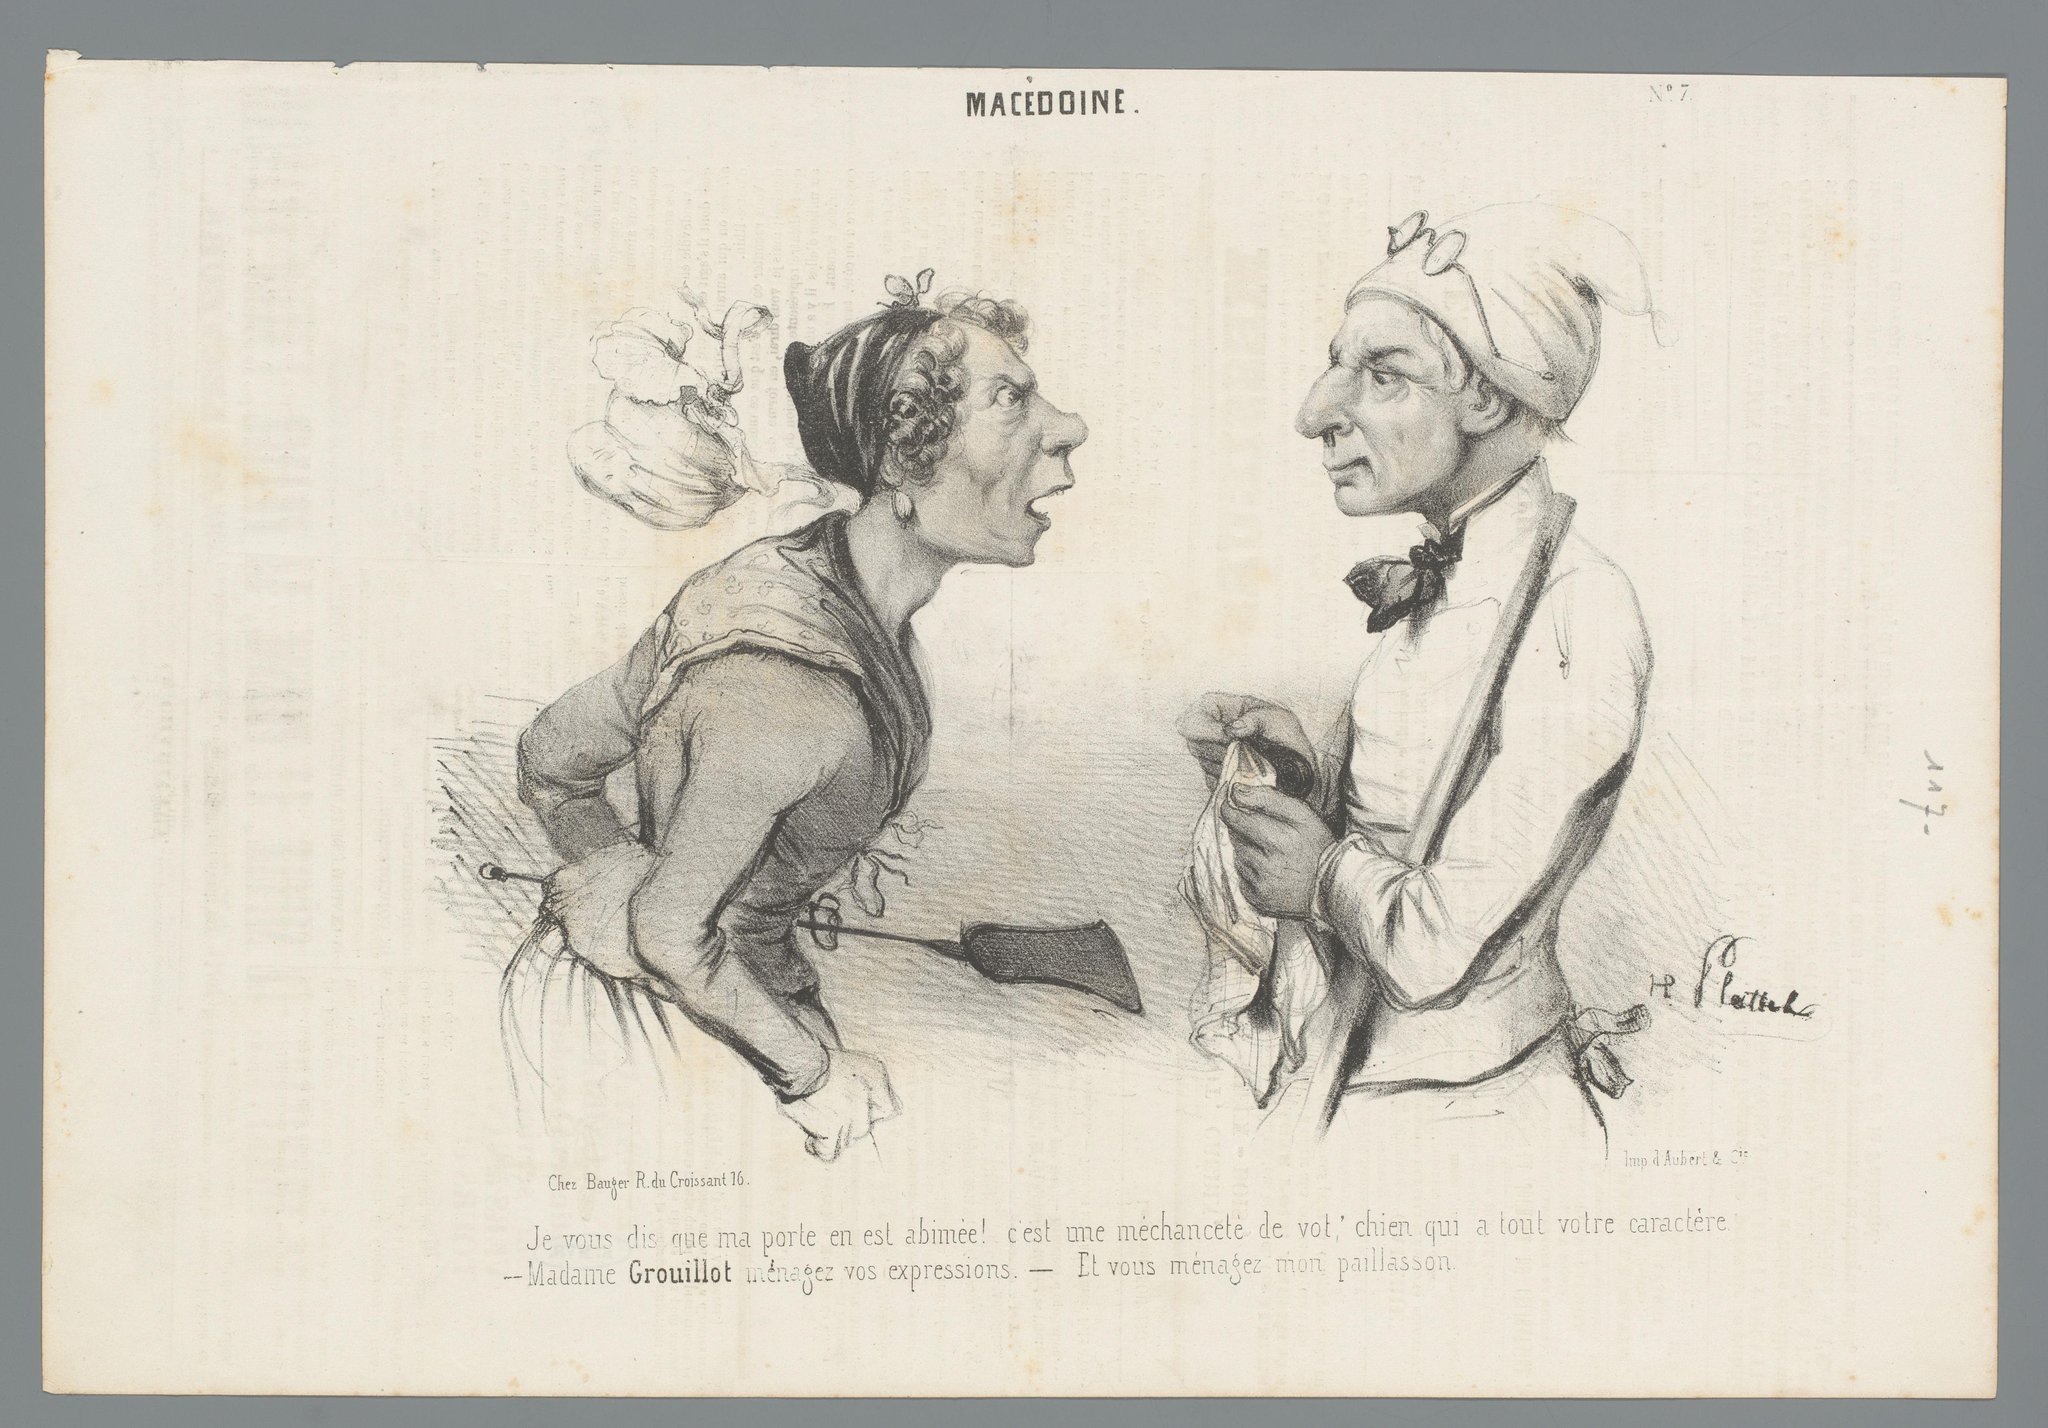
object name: cartoon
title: Macédoine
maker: henri daniel plattel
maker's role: print maker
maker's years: 1803-1859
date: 1840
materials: paper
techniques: letterpress printing, lithograph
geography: paris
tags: adult woman, adult man, crying, shouting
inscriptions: collector's mark: Lugt 2228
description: Onderschrift: Je vous dis que ma porte en est abimée! (...).